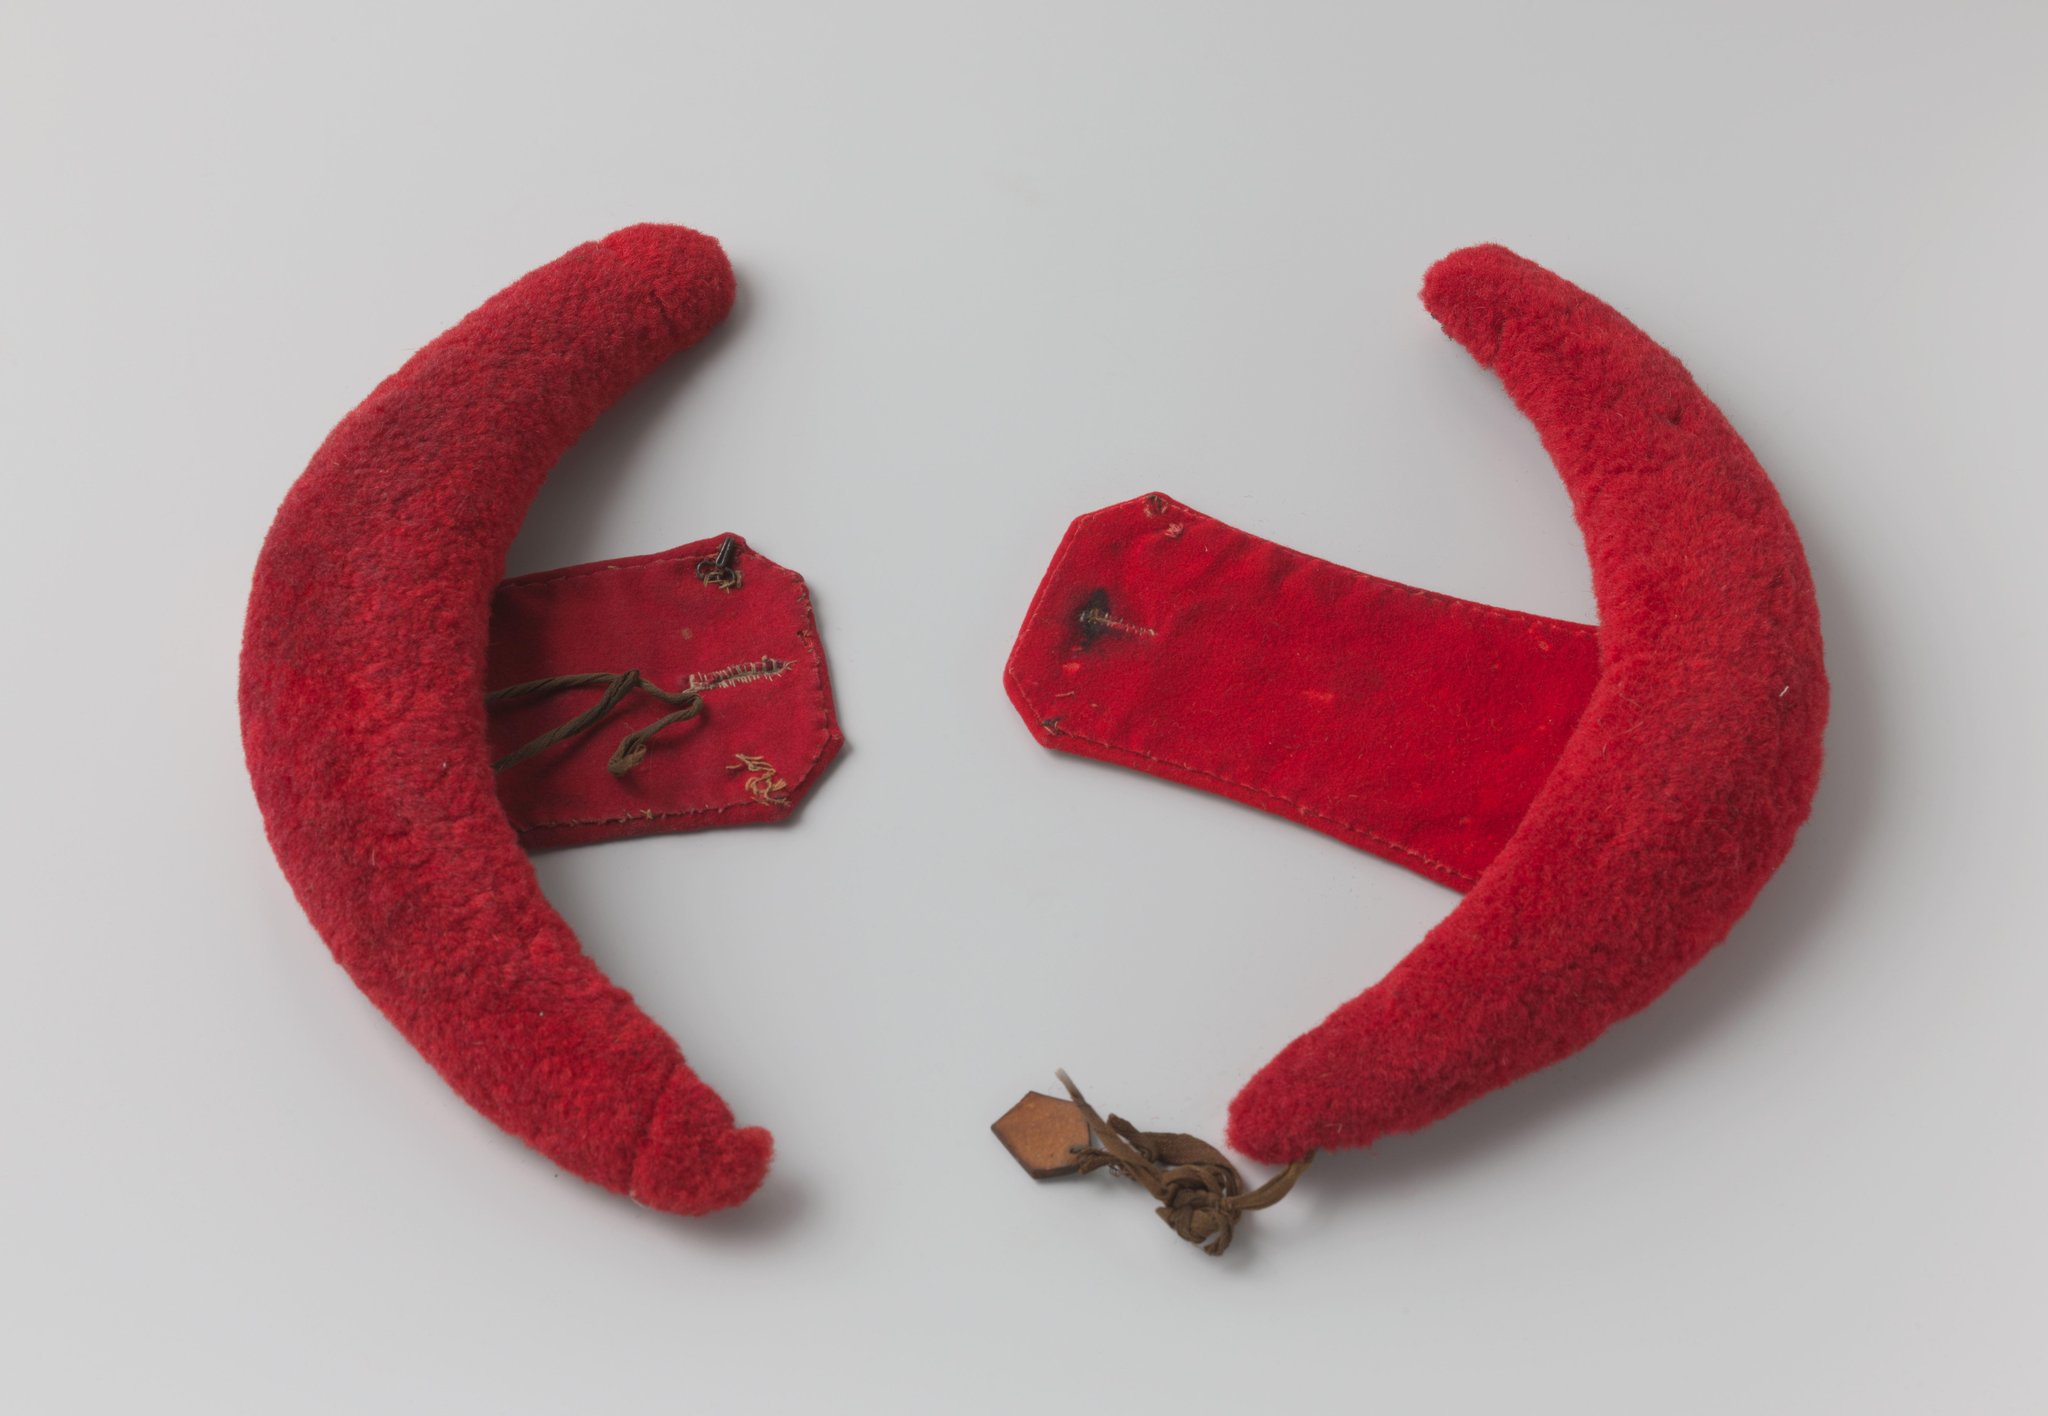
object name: shoulder loop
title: Wings, halfrond van rood wol gevoerd met donkerblauw laken, voor rok grenadiers en flankeurs der grenadiers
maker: Anonymous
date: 1830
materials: textile, metal, wool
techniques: stitching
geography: netherlands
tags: netherlands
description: Halfronde rood wollen schouderbedekking, gevoerd met donkerblauw laken. De schouderbedekking bestaat uit een veter en een epaulet, rood gevoerd (met twee schuine hoeken). Drie gaten en een knoopsgat. De onderzijde heeft een haak ter bevestiging aan de rok. Een haak ontbreekt. In het midden restanten van stiksel.